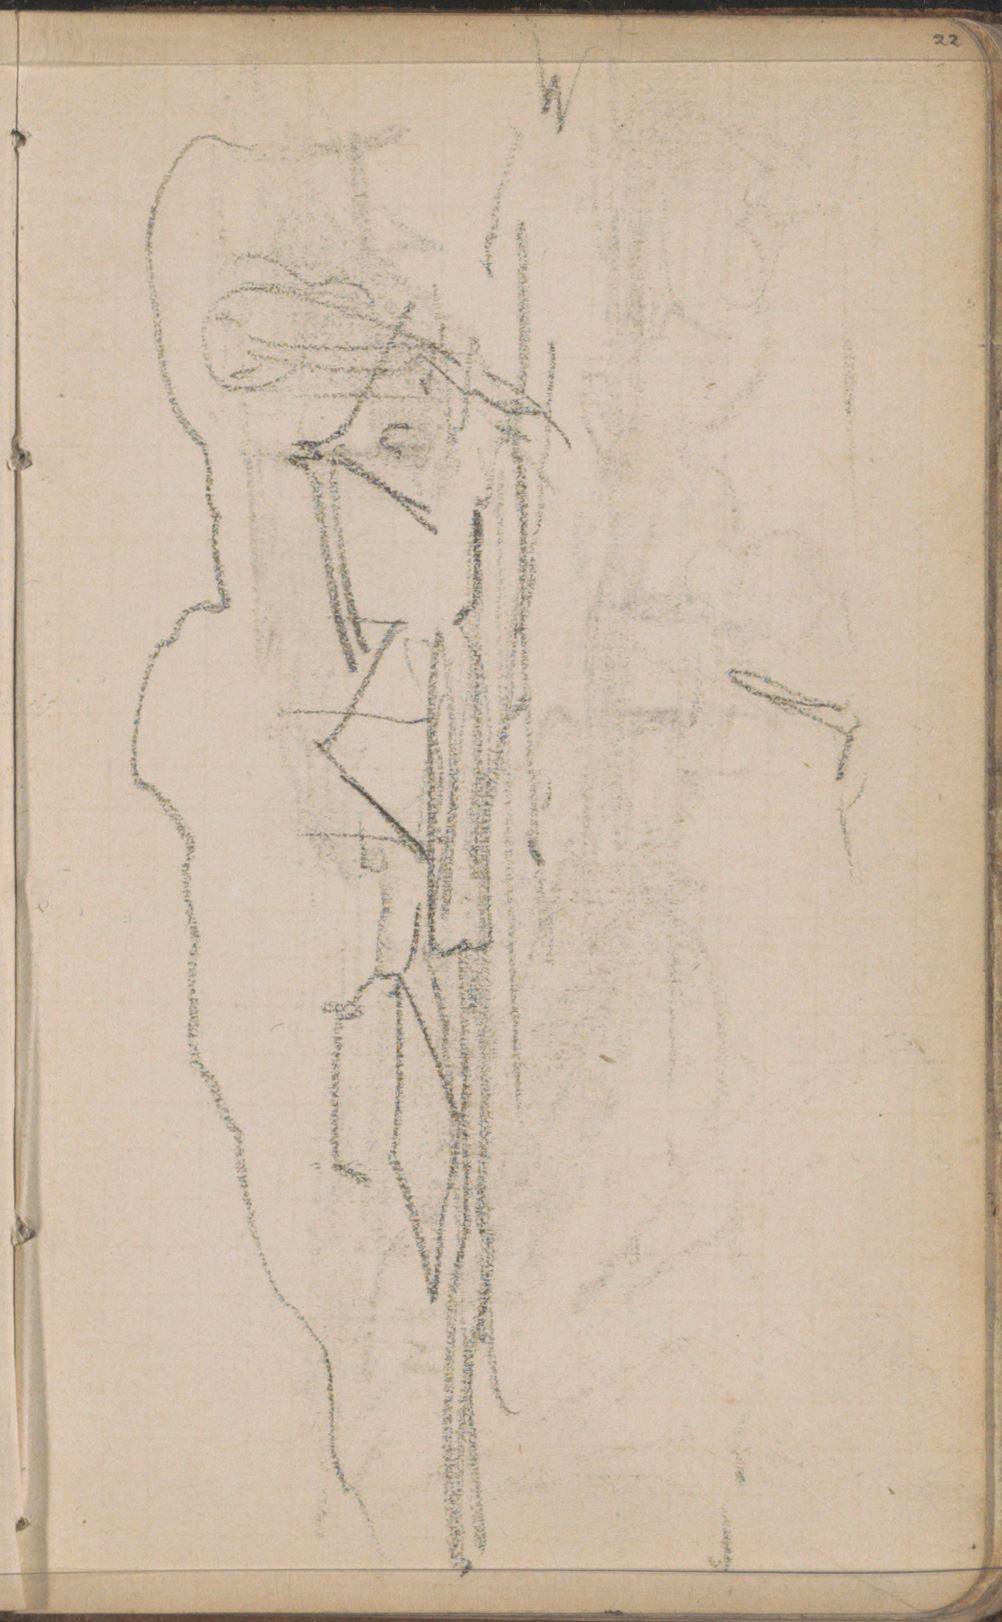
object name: sketchbook leaf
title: Landschap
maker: marius bauer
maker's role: draughtsman, print maker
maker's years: 1867-1932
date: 1879-1885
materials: chalk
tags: landscapes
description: Pagina 22 uit een schetsboek met 58 bladen.